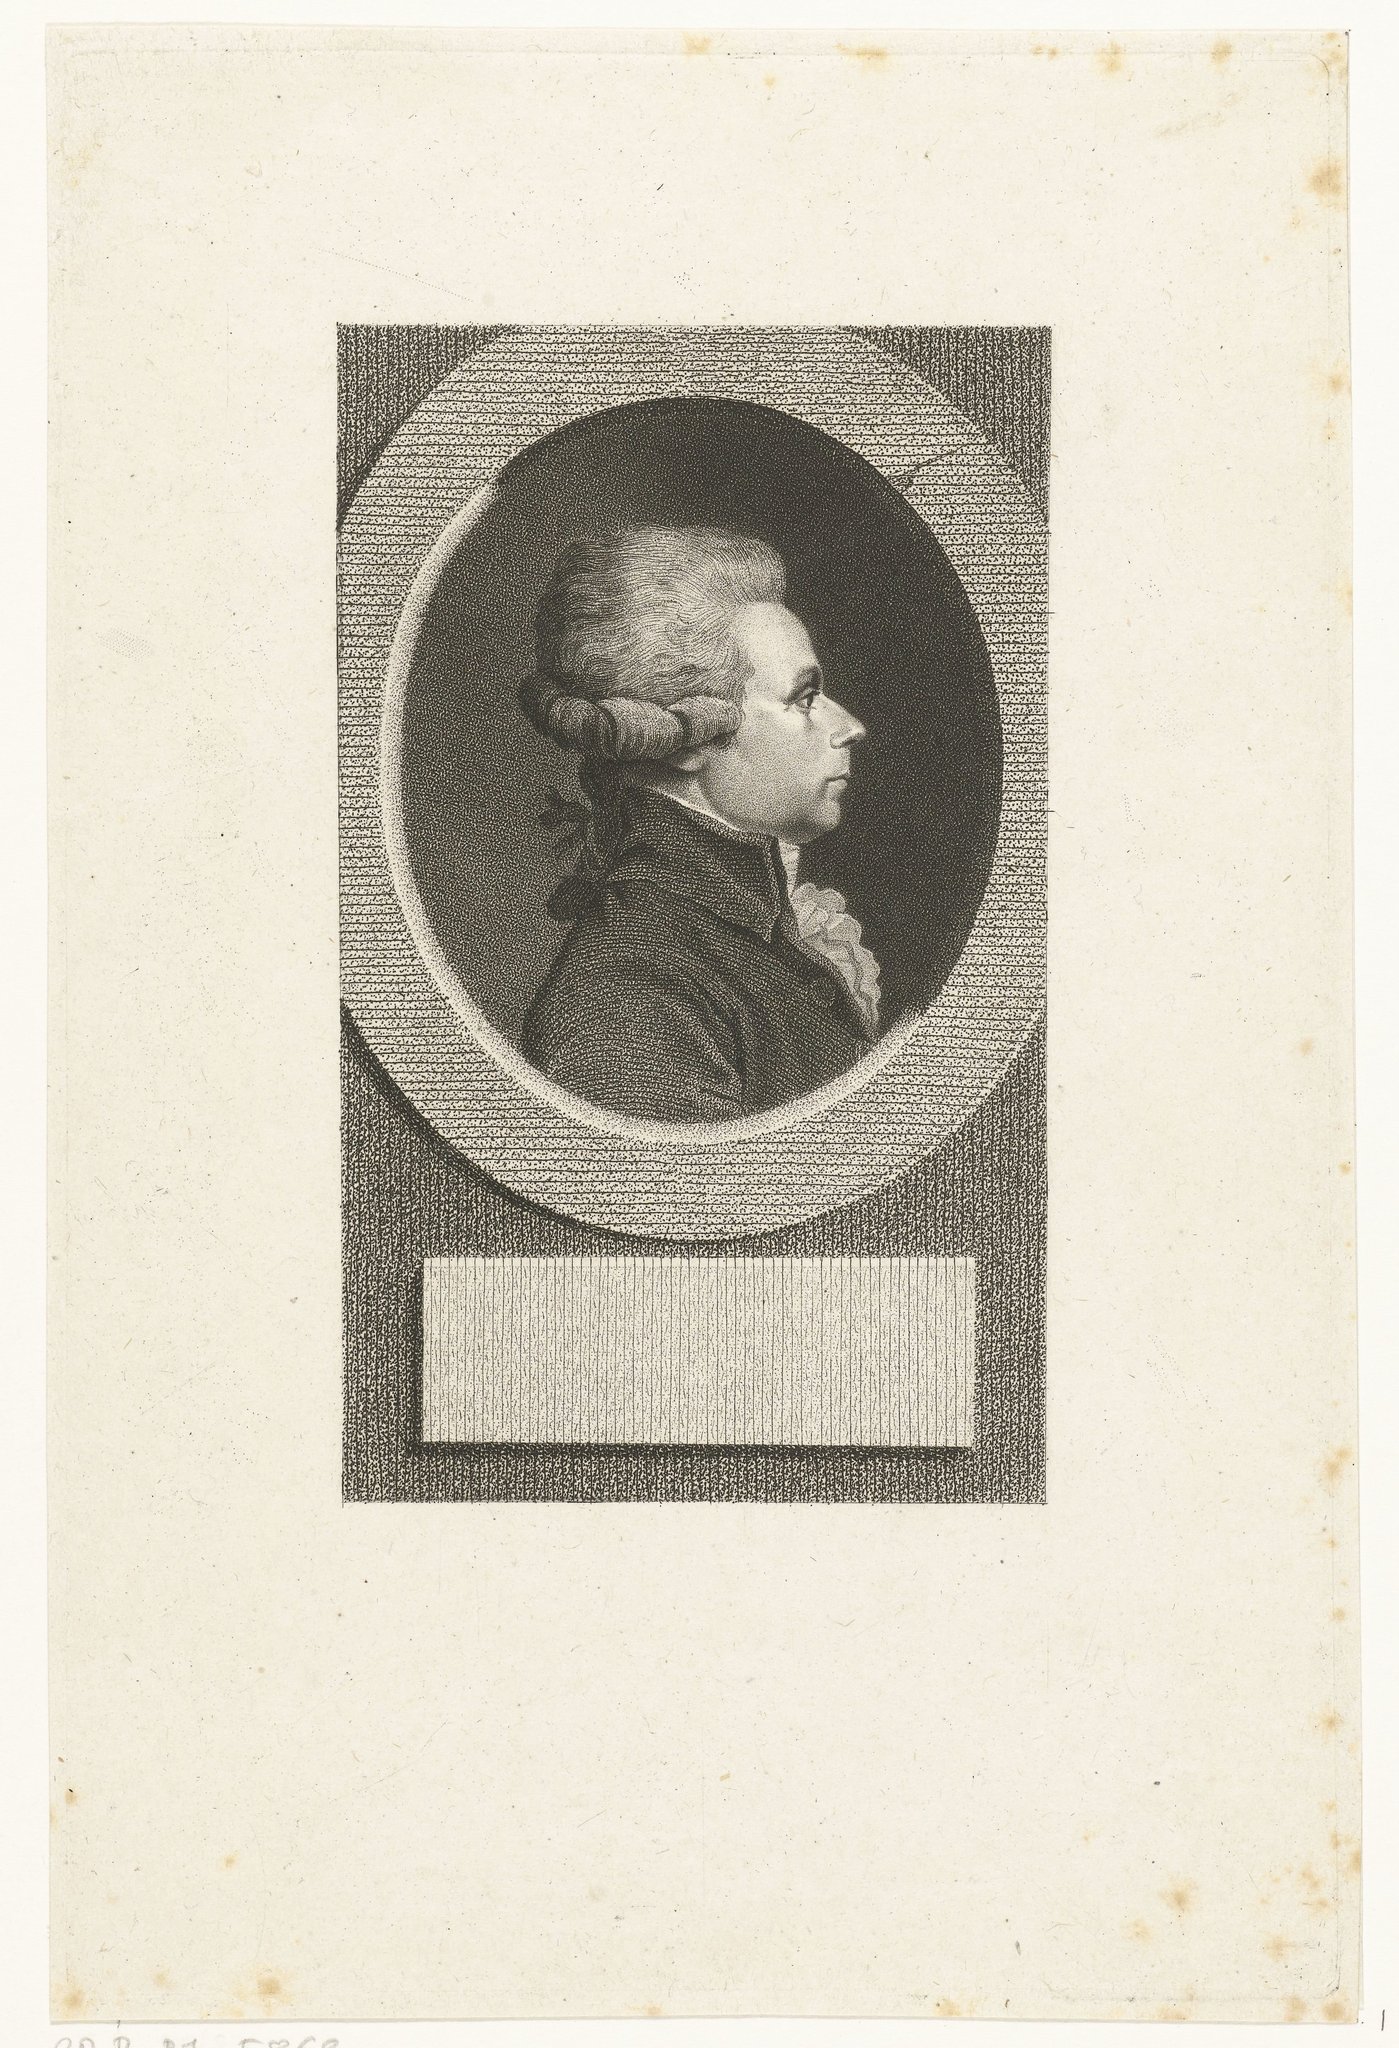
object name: print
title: Portret van Jacques Guillaume Thouret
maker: lambertus antonius claessens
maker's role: draughtsman, print maker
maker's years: 1763-1834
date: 1792-1808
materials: paper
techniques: engraving, etching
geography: amsterdam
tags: paris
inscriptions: collector's mark: Lugt 2228